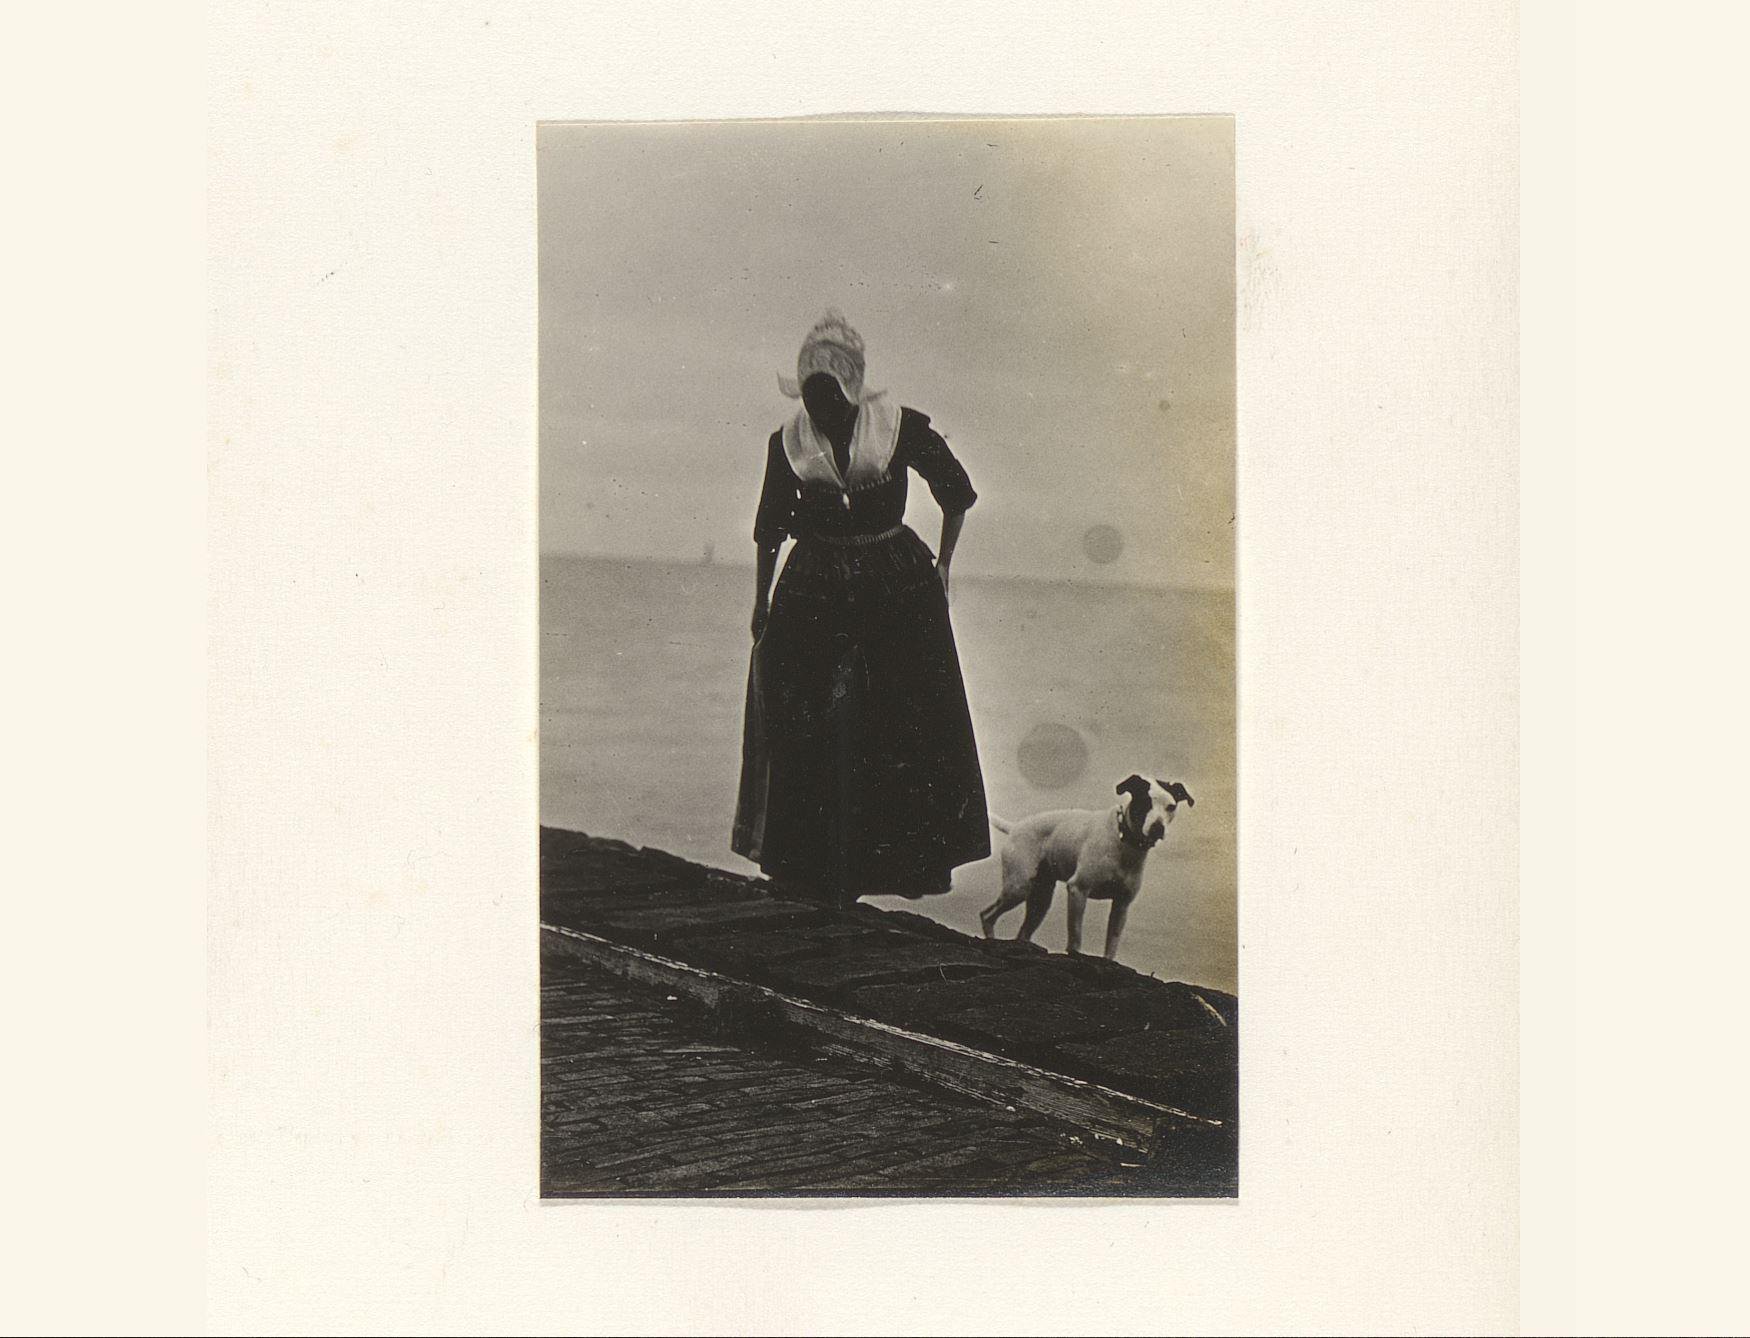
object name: album leaf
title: Vrouw in klederdracht met een hond aan een water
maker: george hidderley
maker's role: fotograaf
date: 1900-1910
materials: paper, photographic support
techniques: gelatin silver print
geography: volendam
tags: adult woman, historical persons, landscapes with waters, waterscapes, seascapes (in the temperate zone), folk costume, regional costume, dog